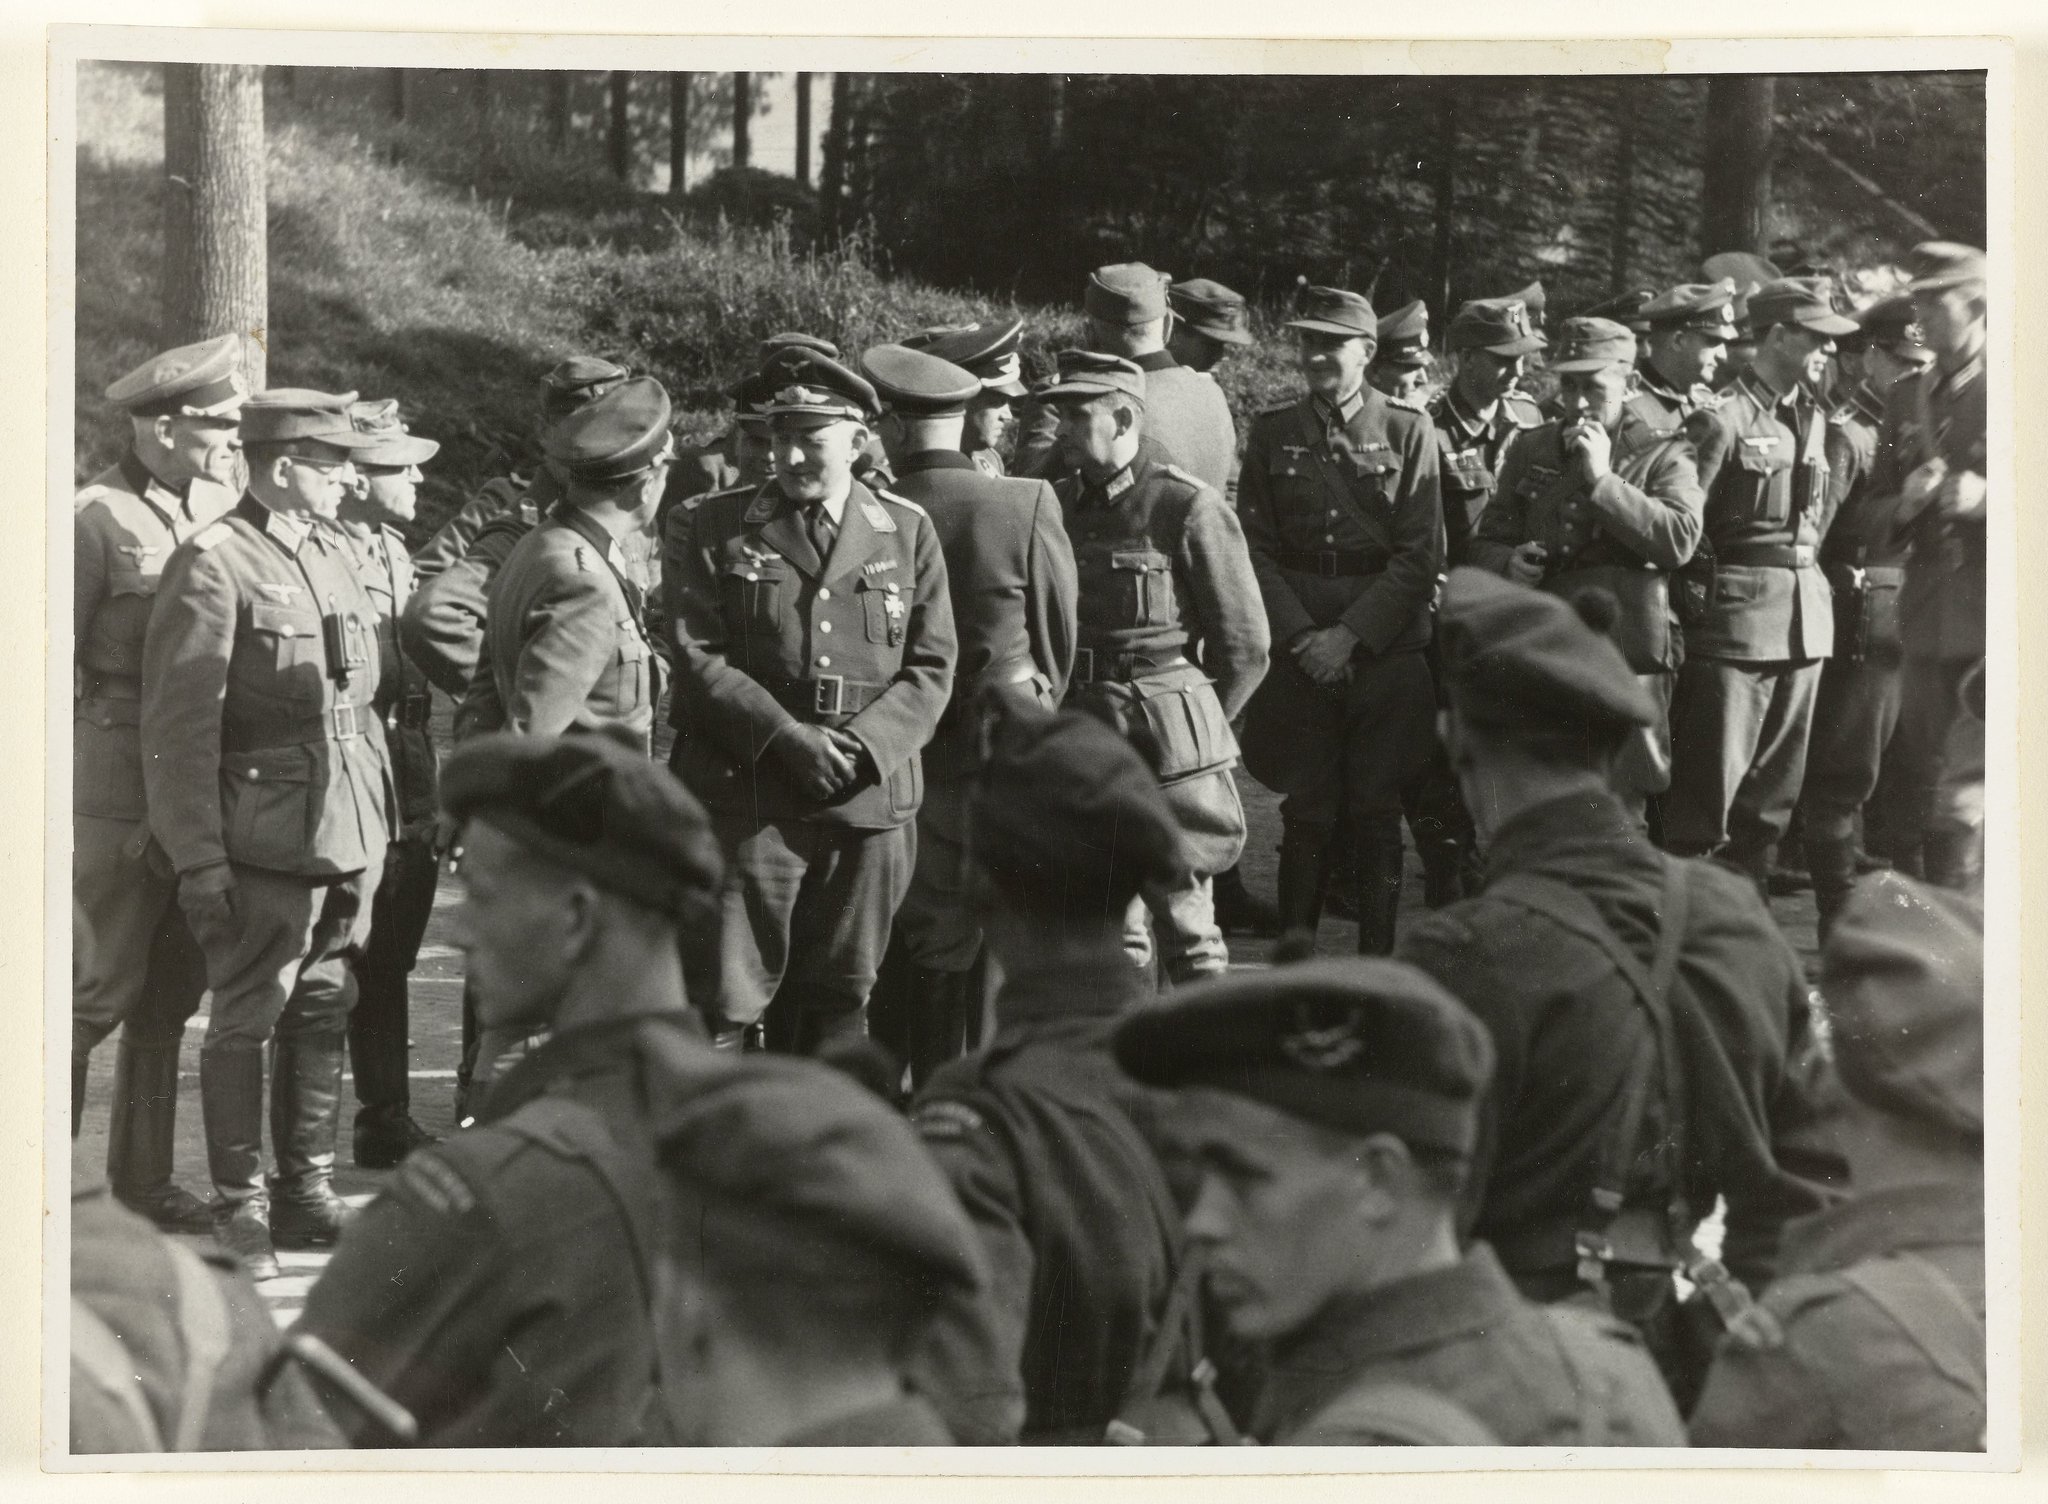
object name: photograph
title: Krijgsgevangen Duitsers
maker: Anonymous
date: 1905-1945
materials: photographic support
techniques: photography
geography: netherlands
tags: prisoner of war (after the battle), netherlands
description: Duitse krijgsgevangenen bewaakt door Engelse? militairen.Op de voorgrond geallieerde militairen, erachter, pratend en rokend, Duitse krijgsgevangenen van de Wehrmacht, o.a de Luftwaffe.